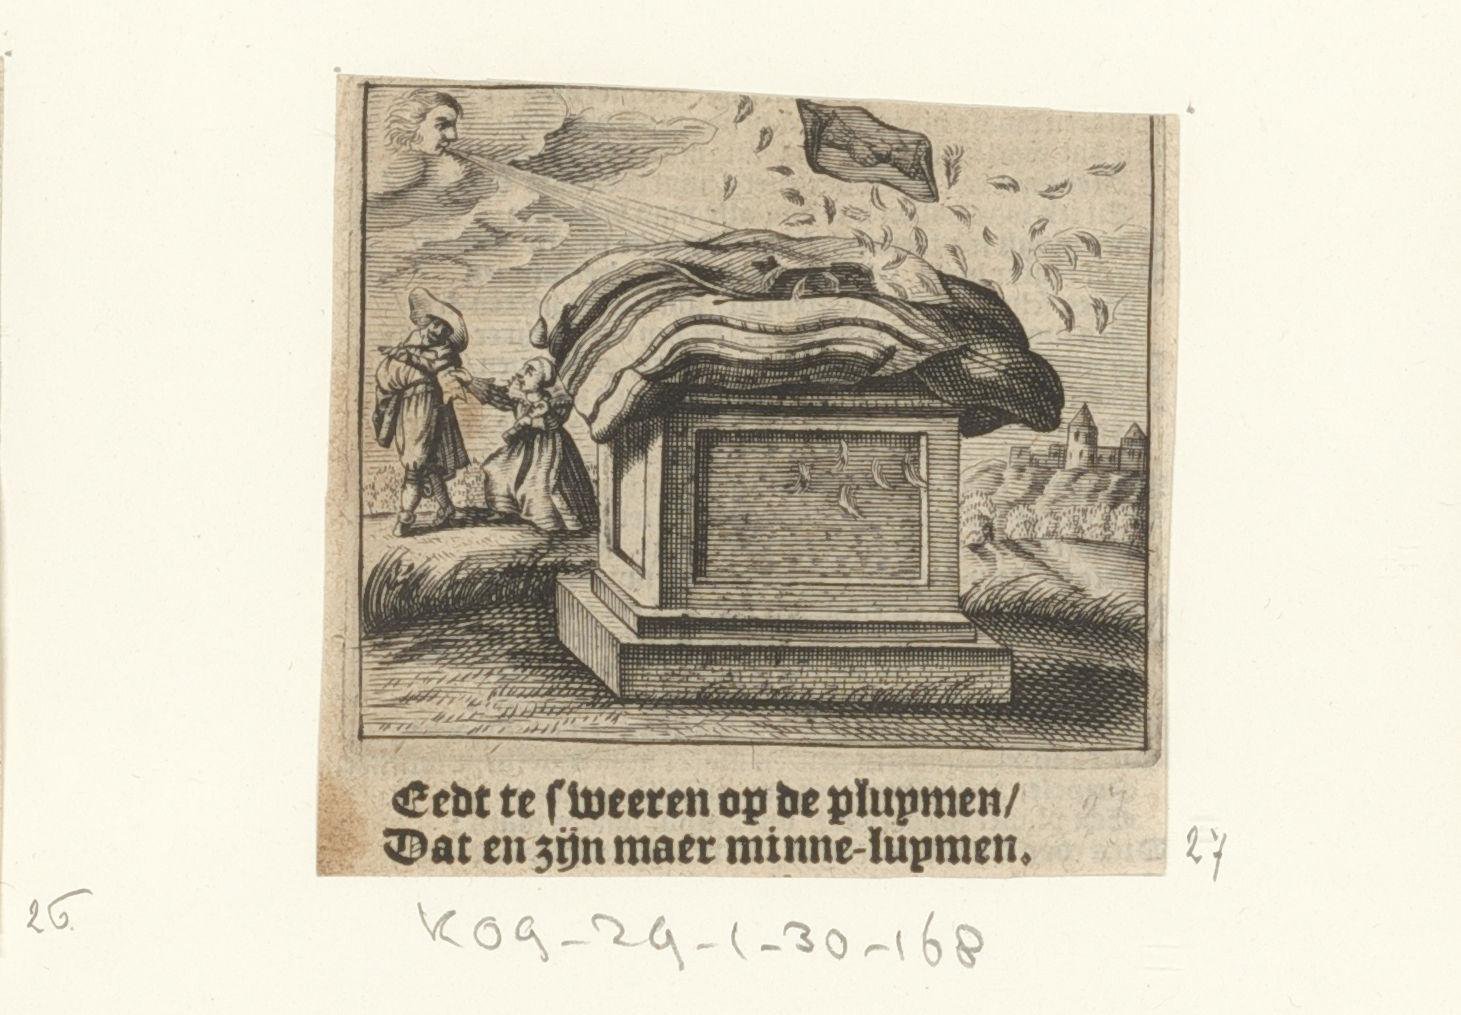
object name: print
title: Veren worden uit een kussen geblazen door de wind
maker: Anonymous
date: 1635-1715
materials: paper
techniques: engraving, letterpress printing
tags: proverbs, sayings, etc., pillow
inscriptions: stamp, collector's mark: Lugt 1641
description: Veel versies van dit embleem verschenen in verschillende uitgave van Spiegel van den Ouden ende Nieuwen Tydt. Zoals: Cats, Jacob. Spiegel van den Ouden ende Nieuwen-tijt, Bestaende uyt Spreeck-woorden (...). Dordrecht: Jacob Braat, 1647. Maar ook in andere publicaties (1665, 1671, 1715, 1722).